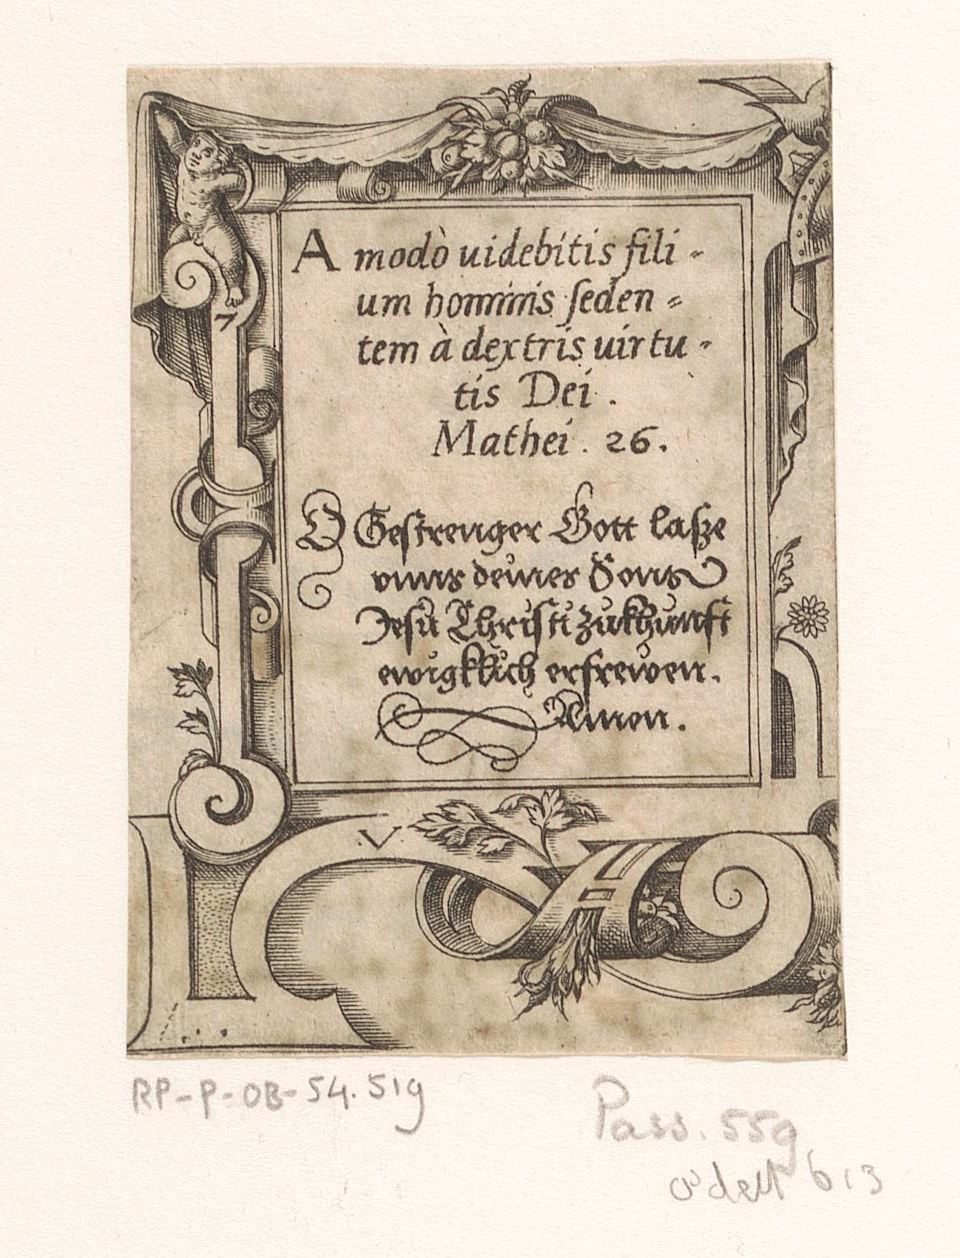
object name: print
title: Gebed in Latijn en Duits in een rolwerk omlijsting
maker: virgilius solis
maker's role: draughtsman, print maker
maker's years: 1514-1562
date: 1568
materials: paper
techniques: engraving, etching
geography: nuremberg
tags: scrollwork, strapwork ~ ornament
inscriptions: number: ‘86’, collector's mark: Lugt 240, collector's mark: Lugt 2228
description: Prent gebruikt voor het gebedenboek: Solis, Virgil. Ein New Künstlich Betbüchlein. Neurenberg: Hieronymus Petri, 1568. Bij elke prent met een Bijbelse scène behoort een genummerde prent met een gebed in het Latijn en in het Duits. Het monogram VS is steeds verspreid over twee bij elkaar horende prenten.